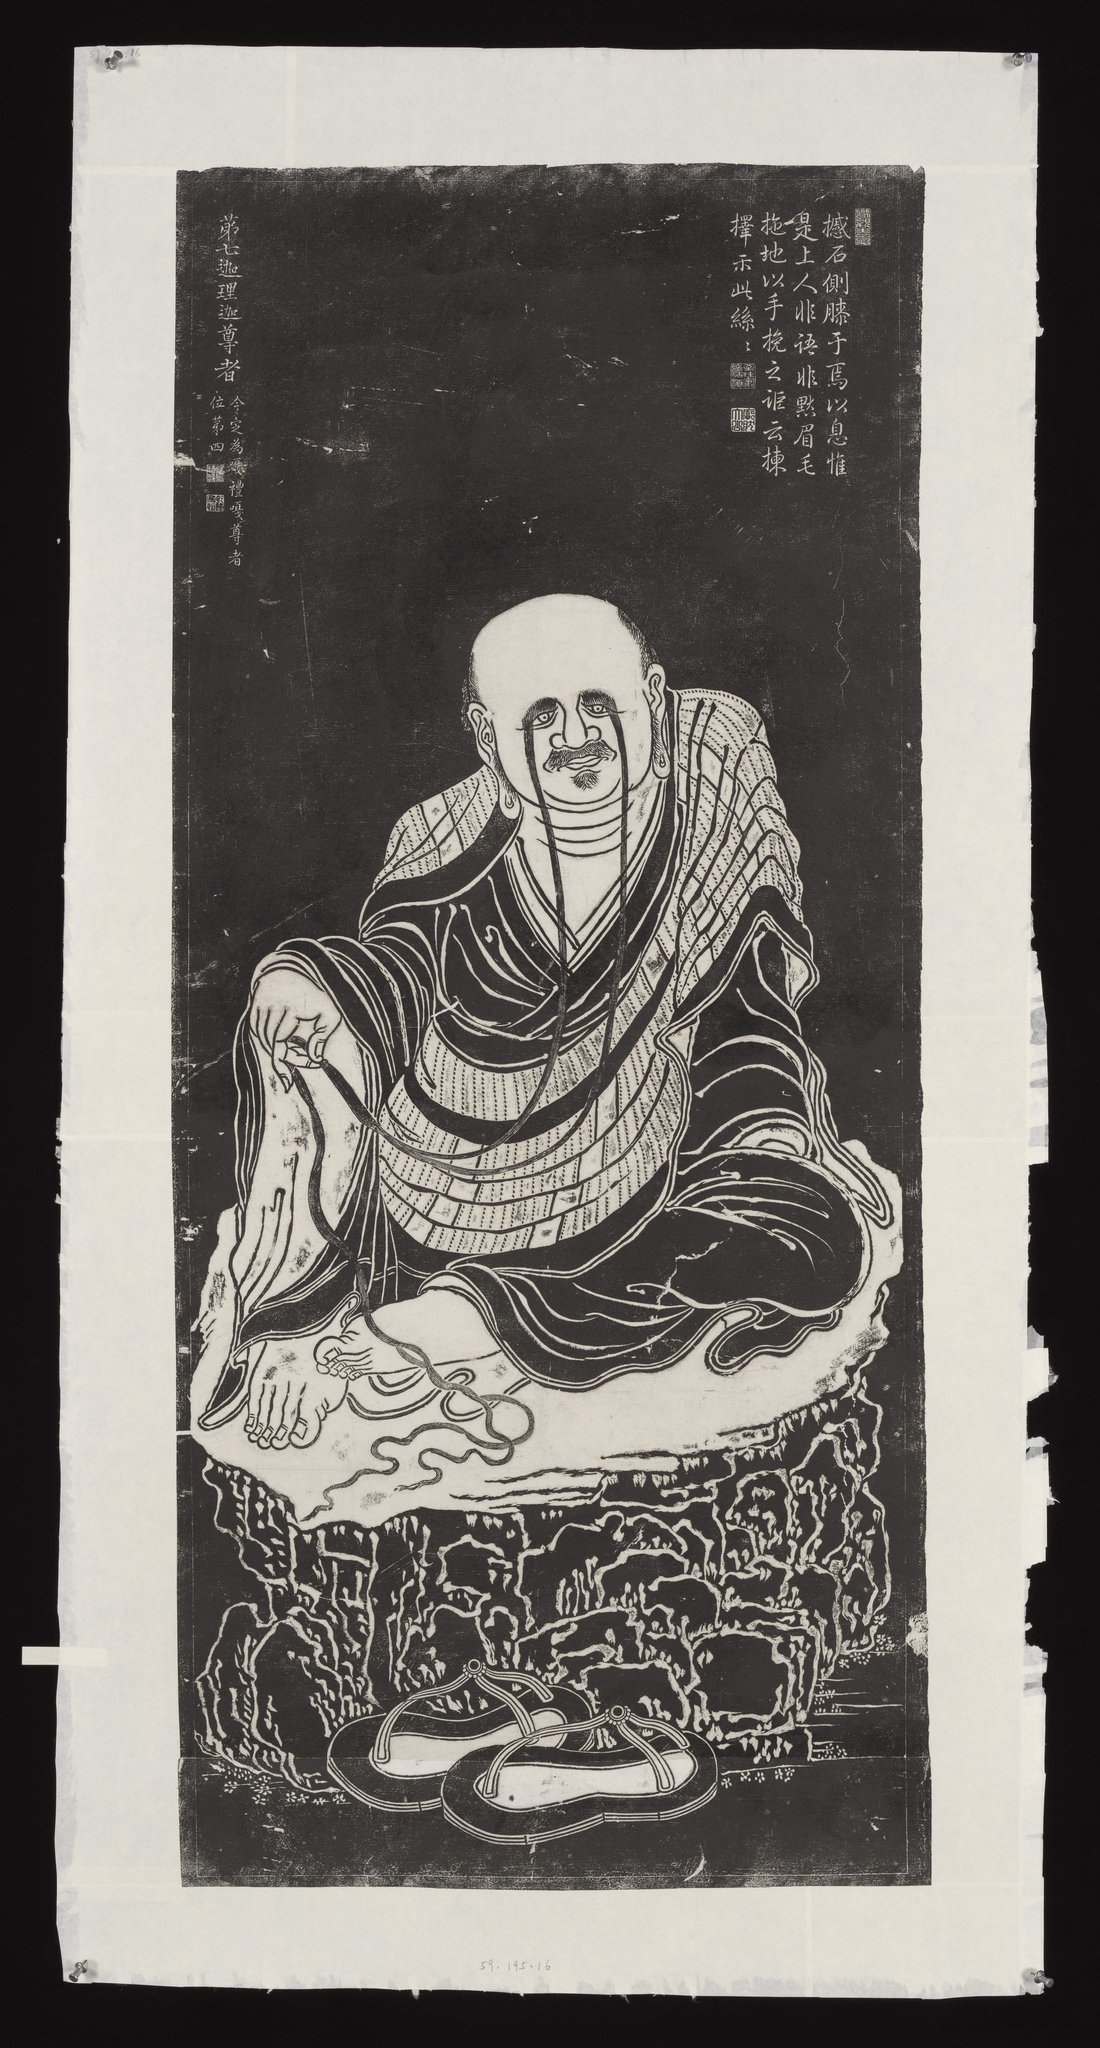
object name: rubbing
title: Luohan, after a set attributed to Guanxiu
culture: chinese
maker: unidentified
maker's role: artist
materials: ink, paper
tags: men